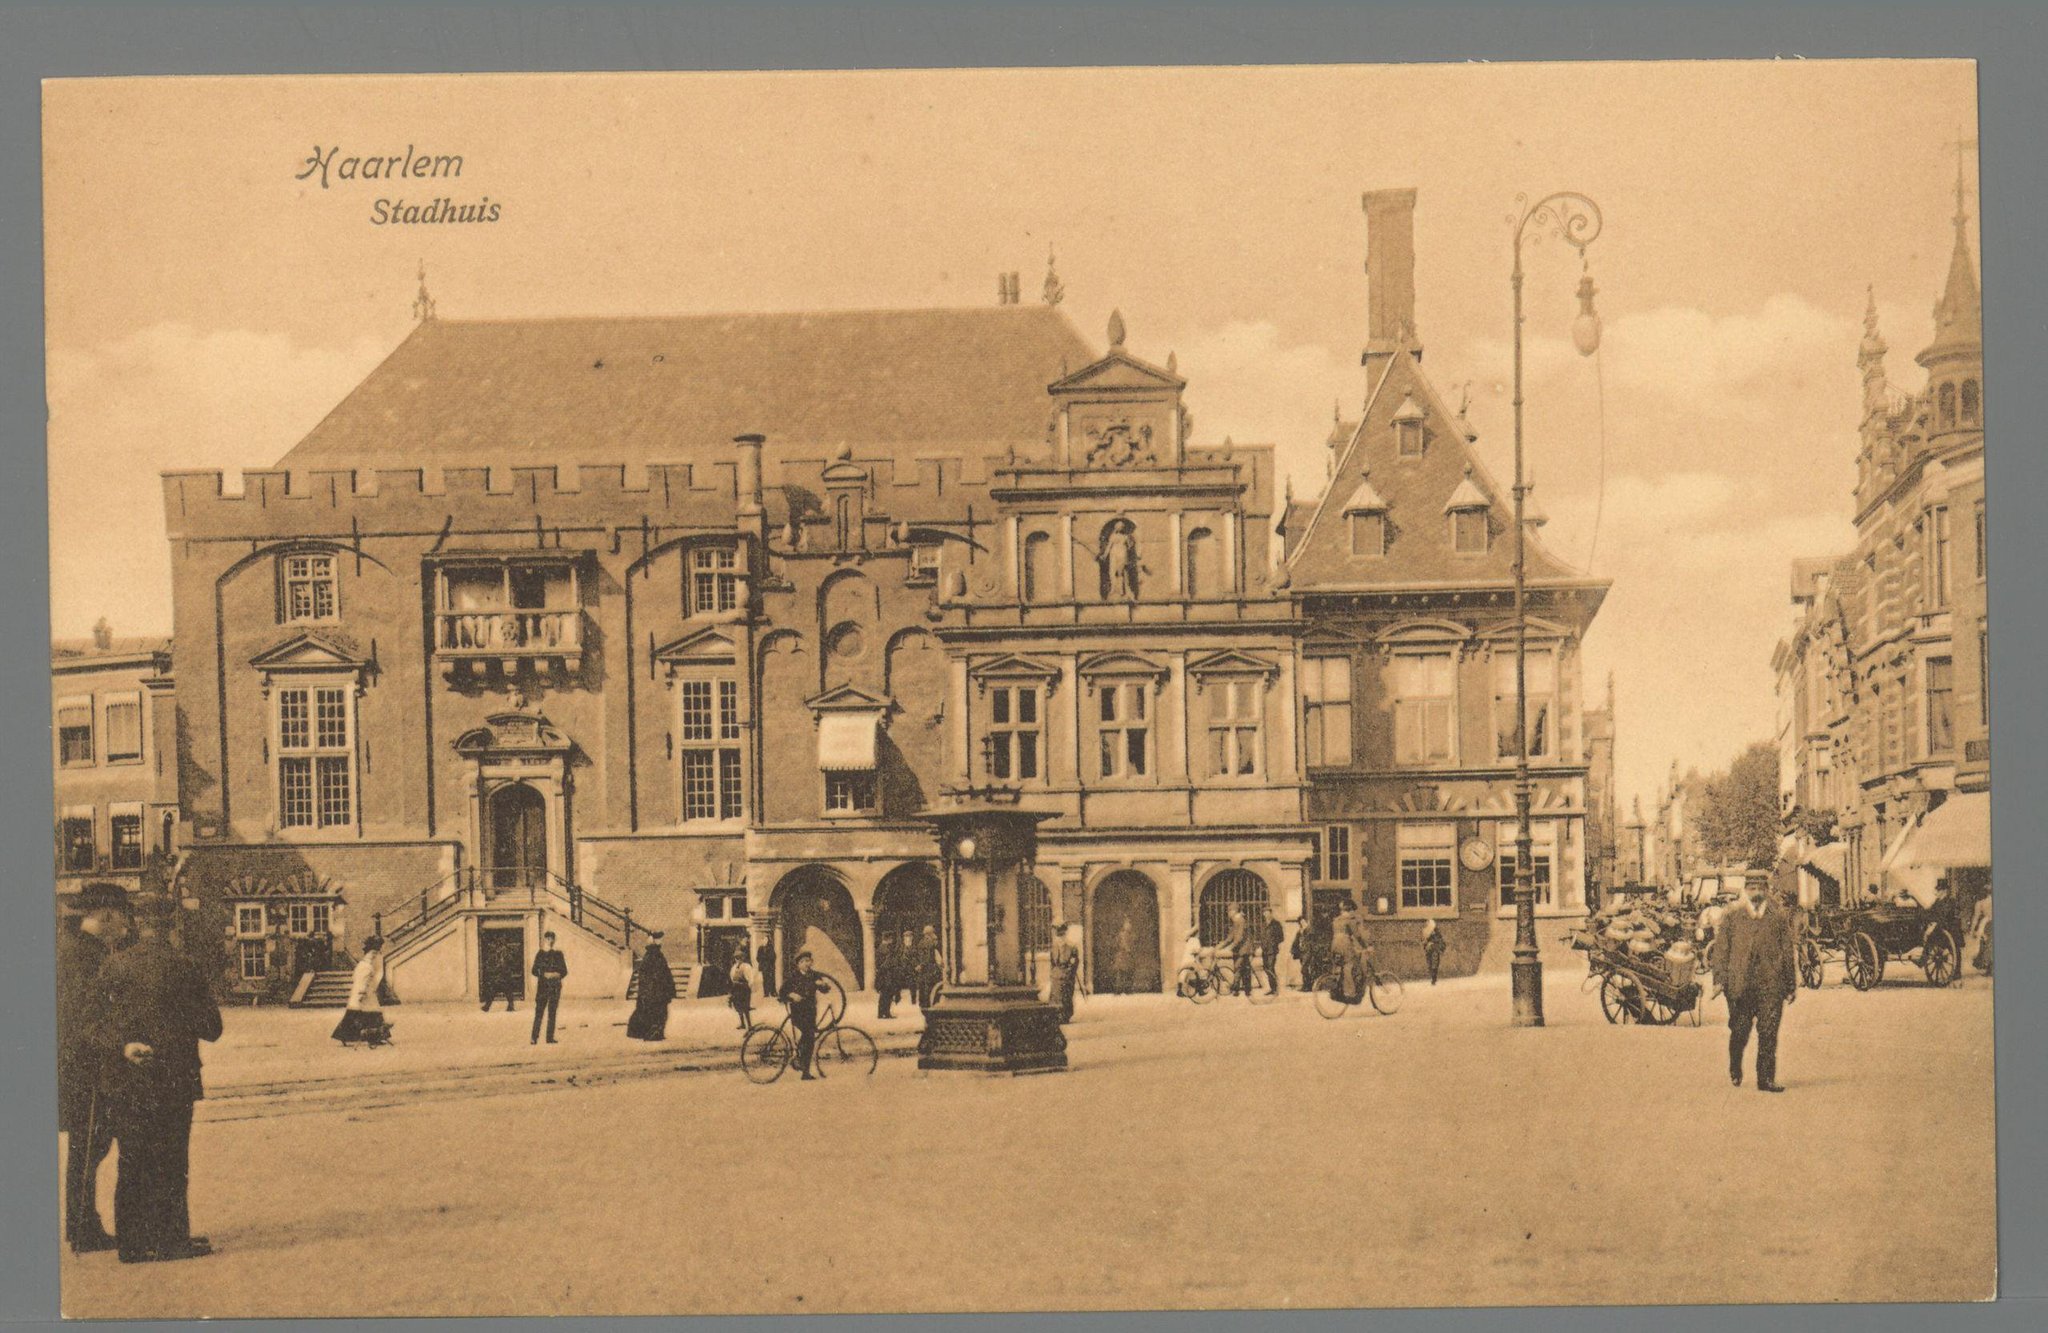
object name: ansichtkaart, prentbriefkaart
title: Haarlem. Stadhuis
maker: Anonymous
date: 1911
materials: cardboard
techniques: photograph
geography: haarlem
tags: city-view, and landscape with man-made constructions, townhall, haarlem